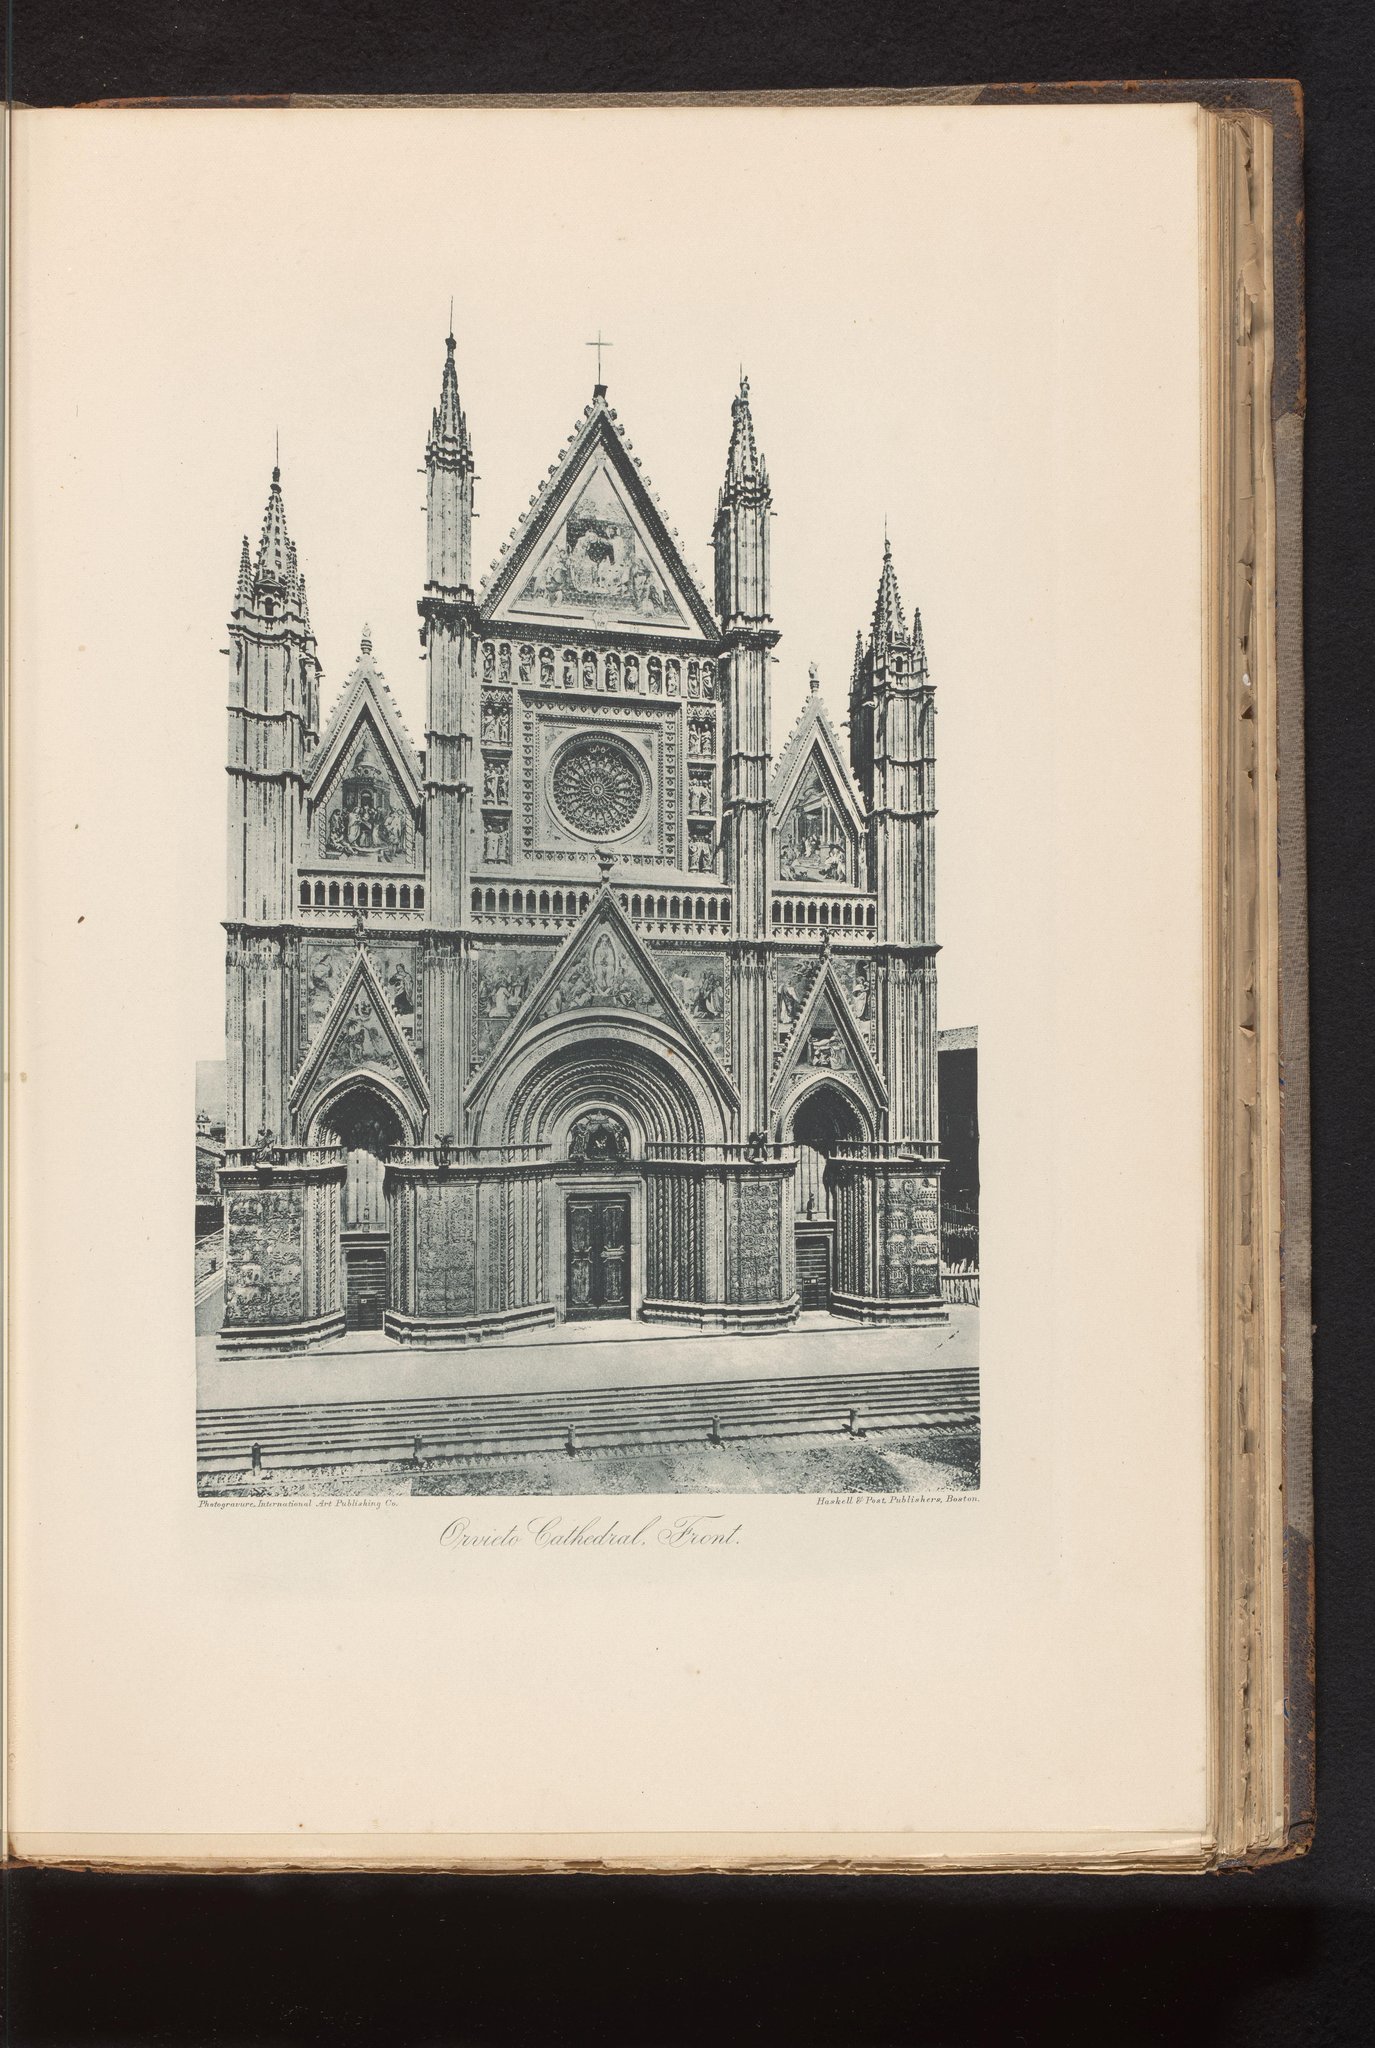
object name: photomechanical print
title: Orvieto Cathedral, Front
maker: Anonymous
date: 1881-1886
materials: paper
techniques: photograph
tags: church (exterior)